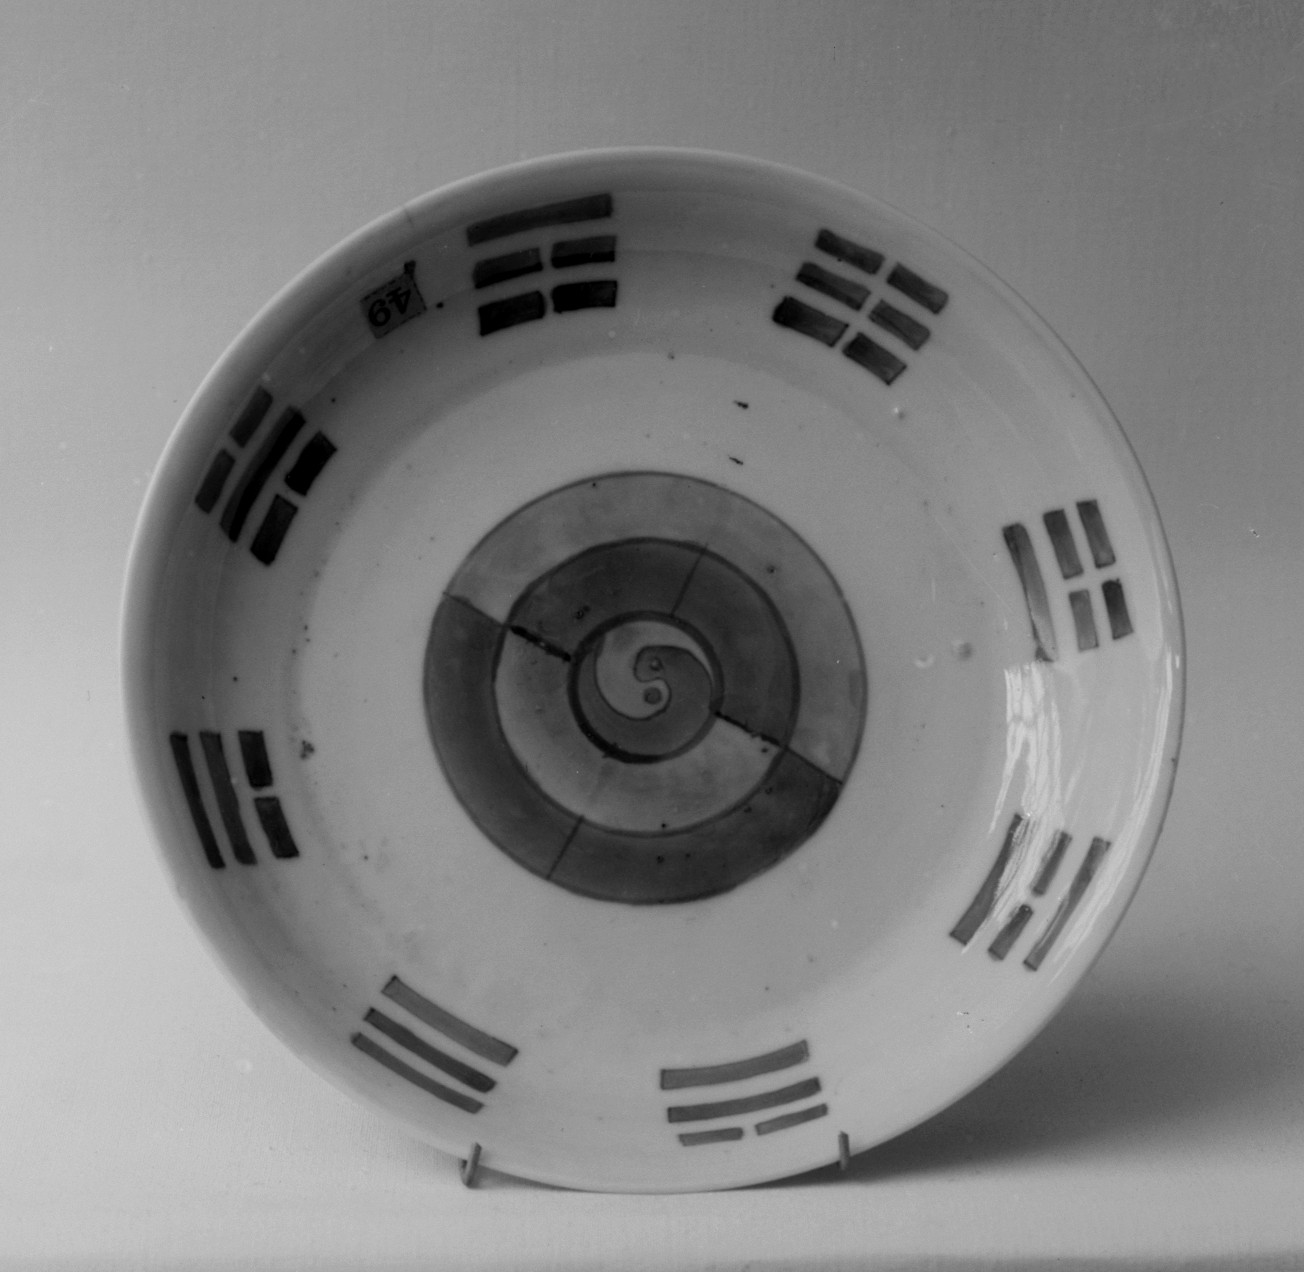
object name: dish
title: Dish with eight trigrams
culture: chinese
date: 1701-1800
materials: cobalt, porcelain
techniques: painting, underglaze